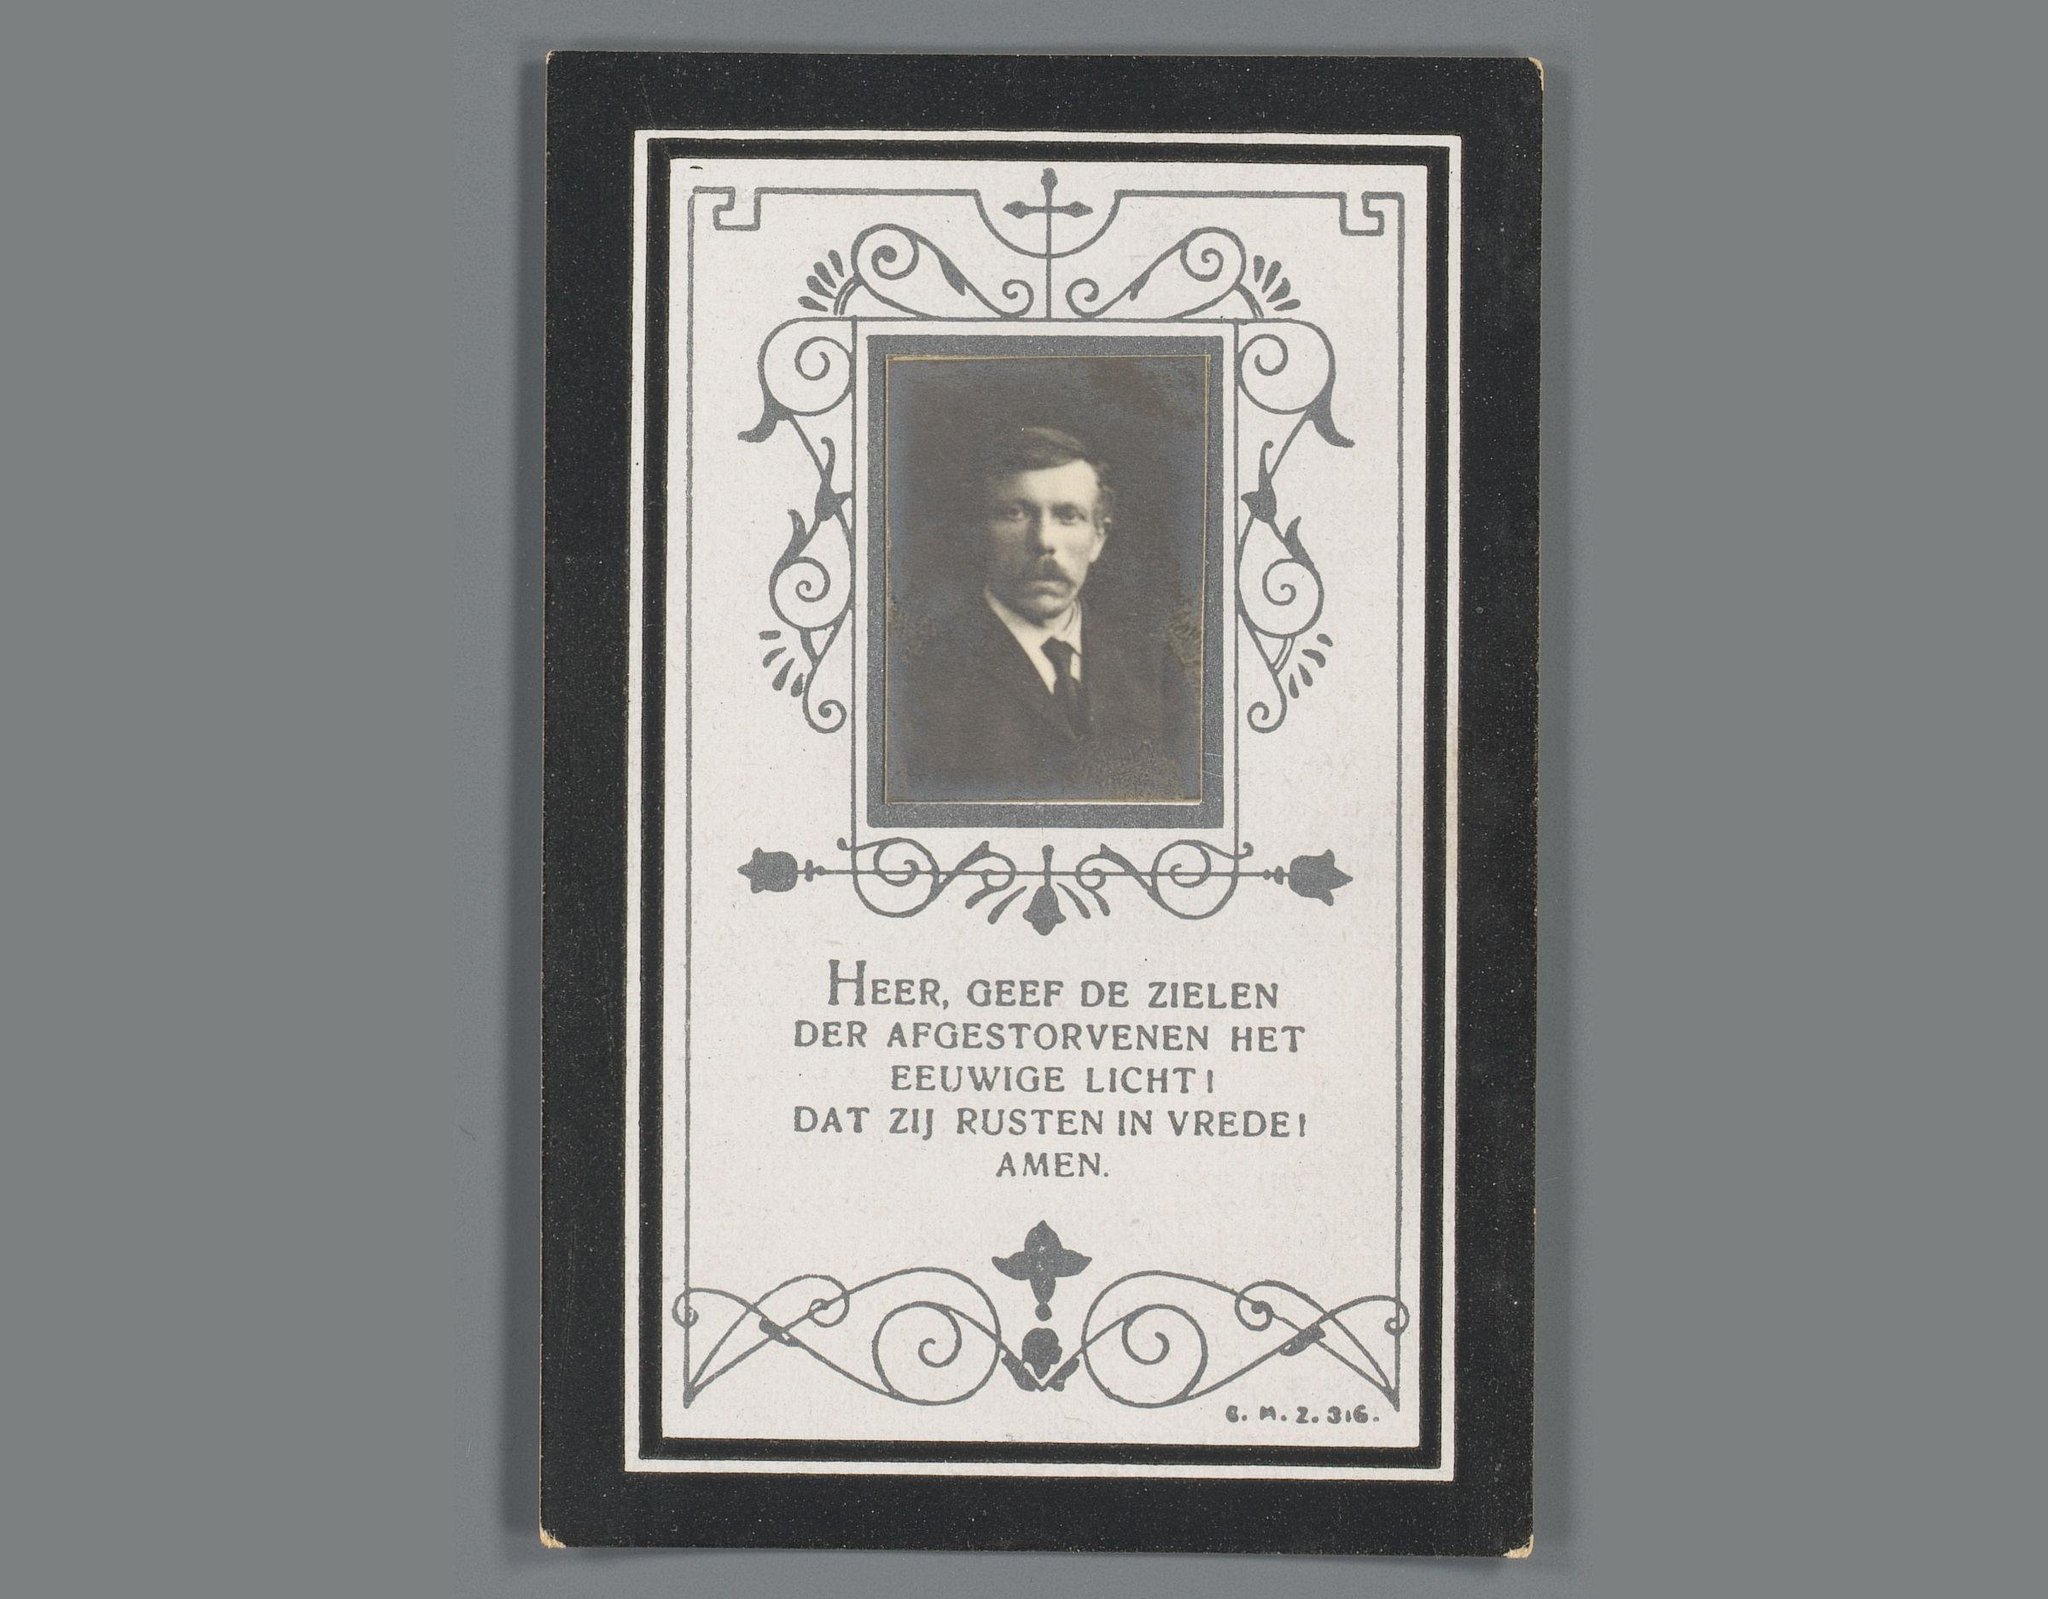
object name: photograph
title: Portret van Adrianus Blokdijk op bidprent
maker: Anonymous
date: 1931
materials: paper, cardboard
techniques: gelatin silver print, letterpress printing, lithograph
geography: hoorn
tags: adult man, historical persons, hoorn (north holland)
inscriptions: inscription: ‘Heer, geef de zielen/ der afgestorvenen het/ eeuwige licht!/ Dat zij rusten in vrede!/ Amen./ C.M.Z. [?] 316.’, inscription: ‘Bid voor de Ziel van Zaliger (...) helpt mij door uwe gebeden bij God./ Wed. W.H. Castricum - Hoorn’